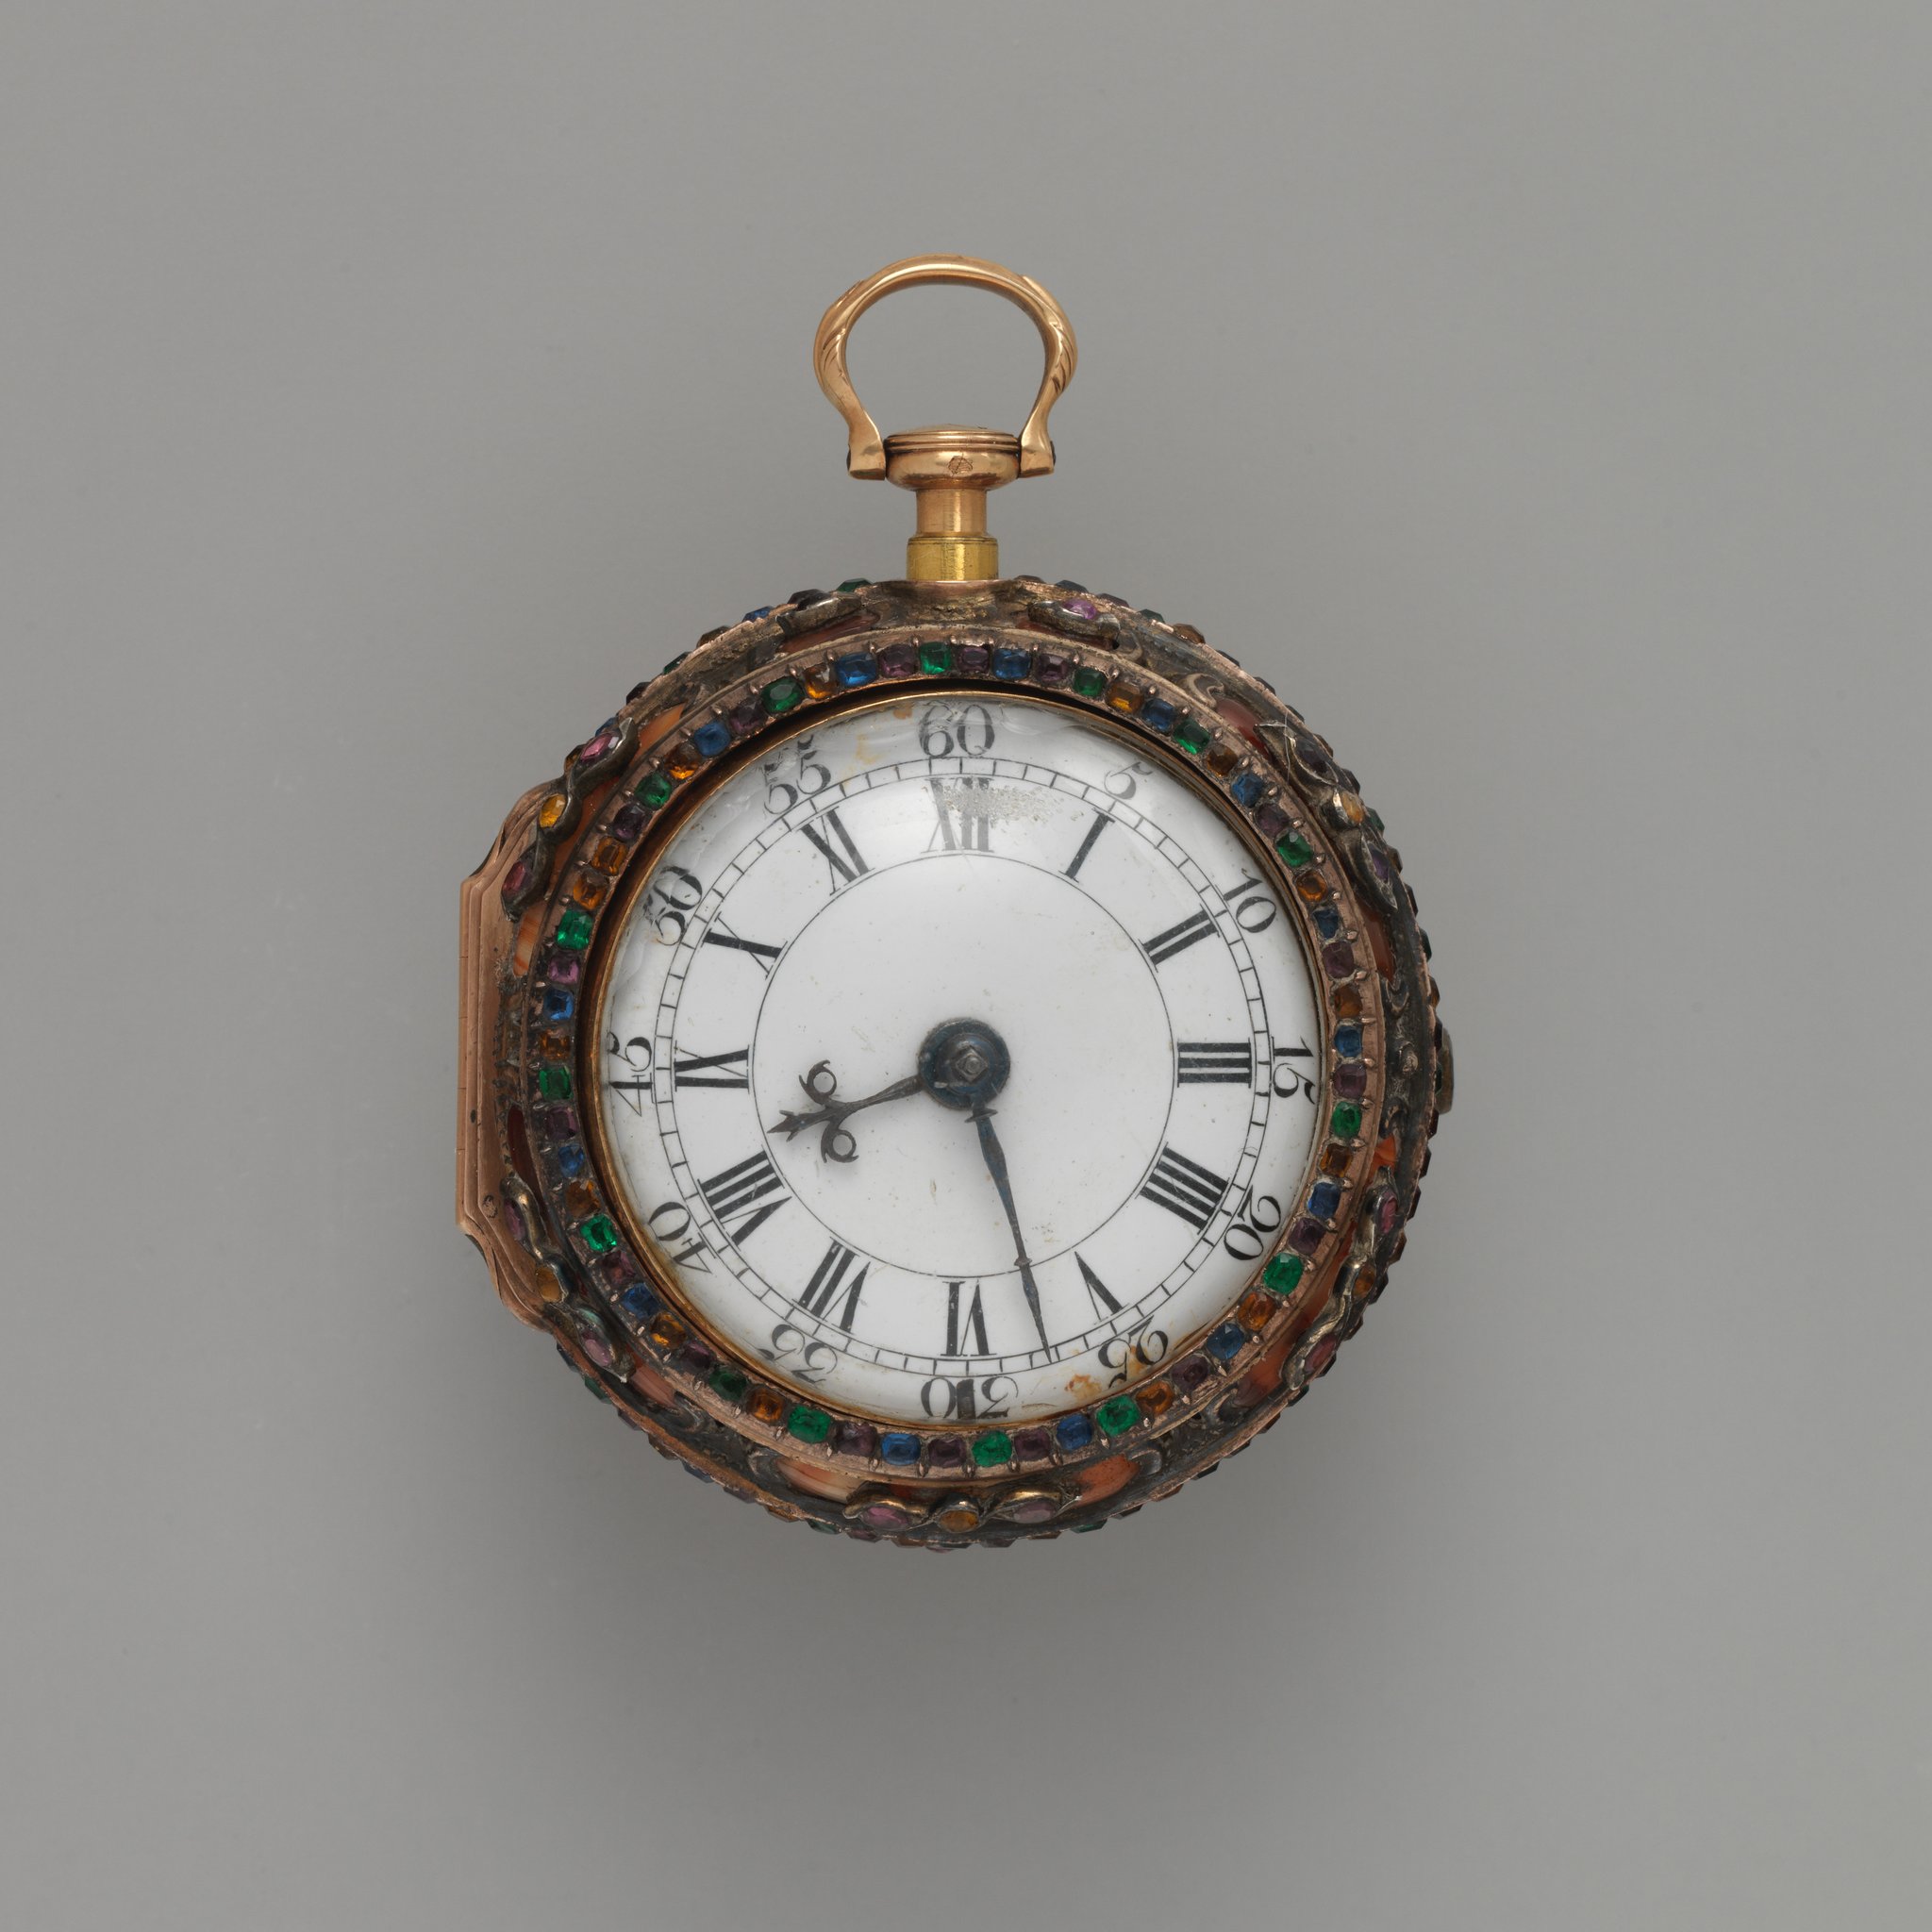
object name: repeating watch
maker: george goodman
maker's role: maker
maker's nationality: british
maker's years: 1771-1785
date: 1780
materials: stone, amethyst, diamond, gemstone, gold